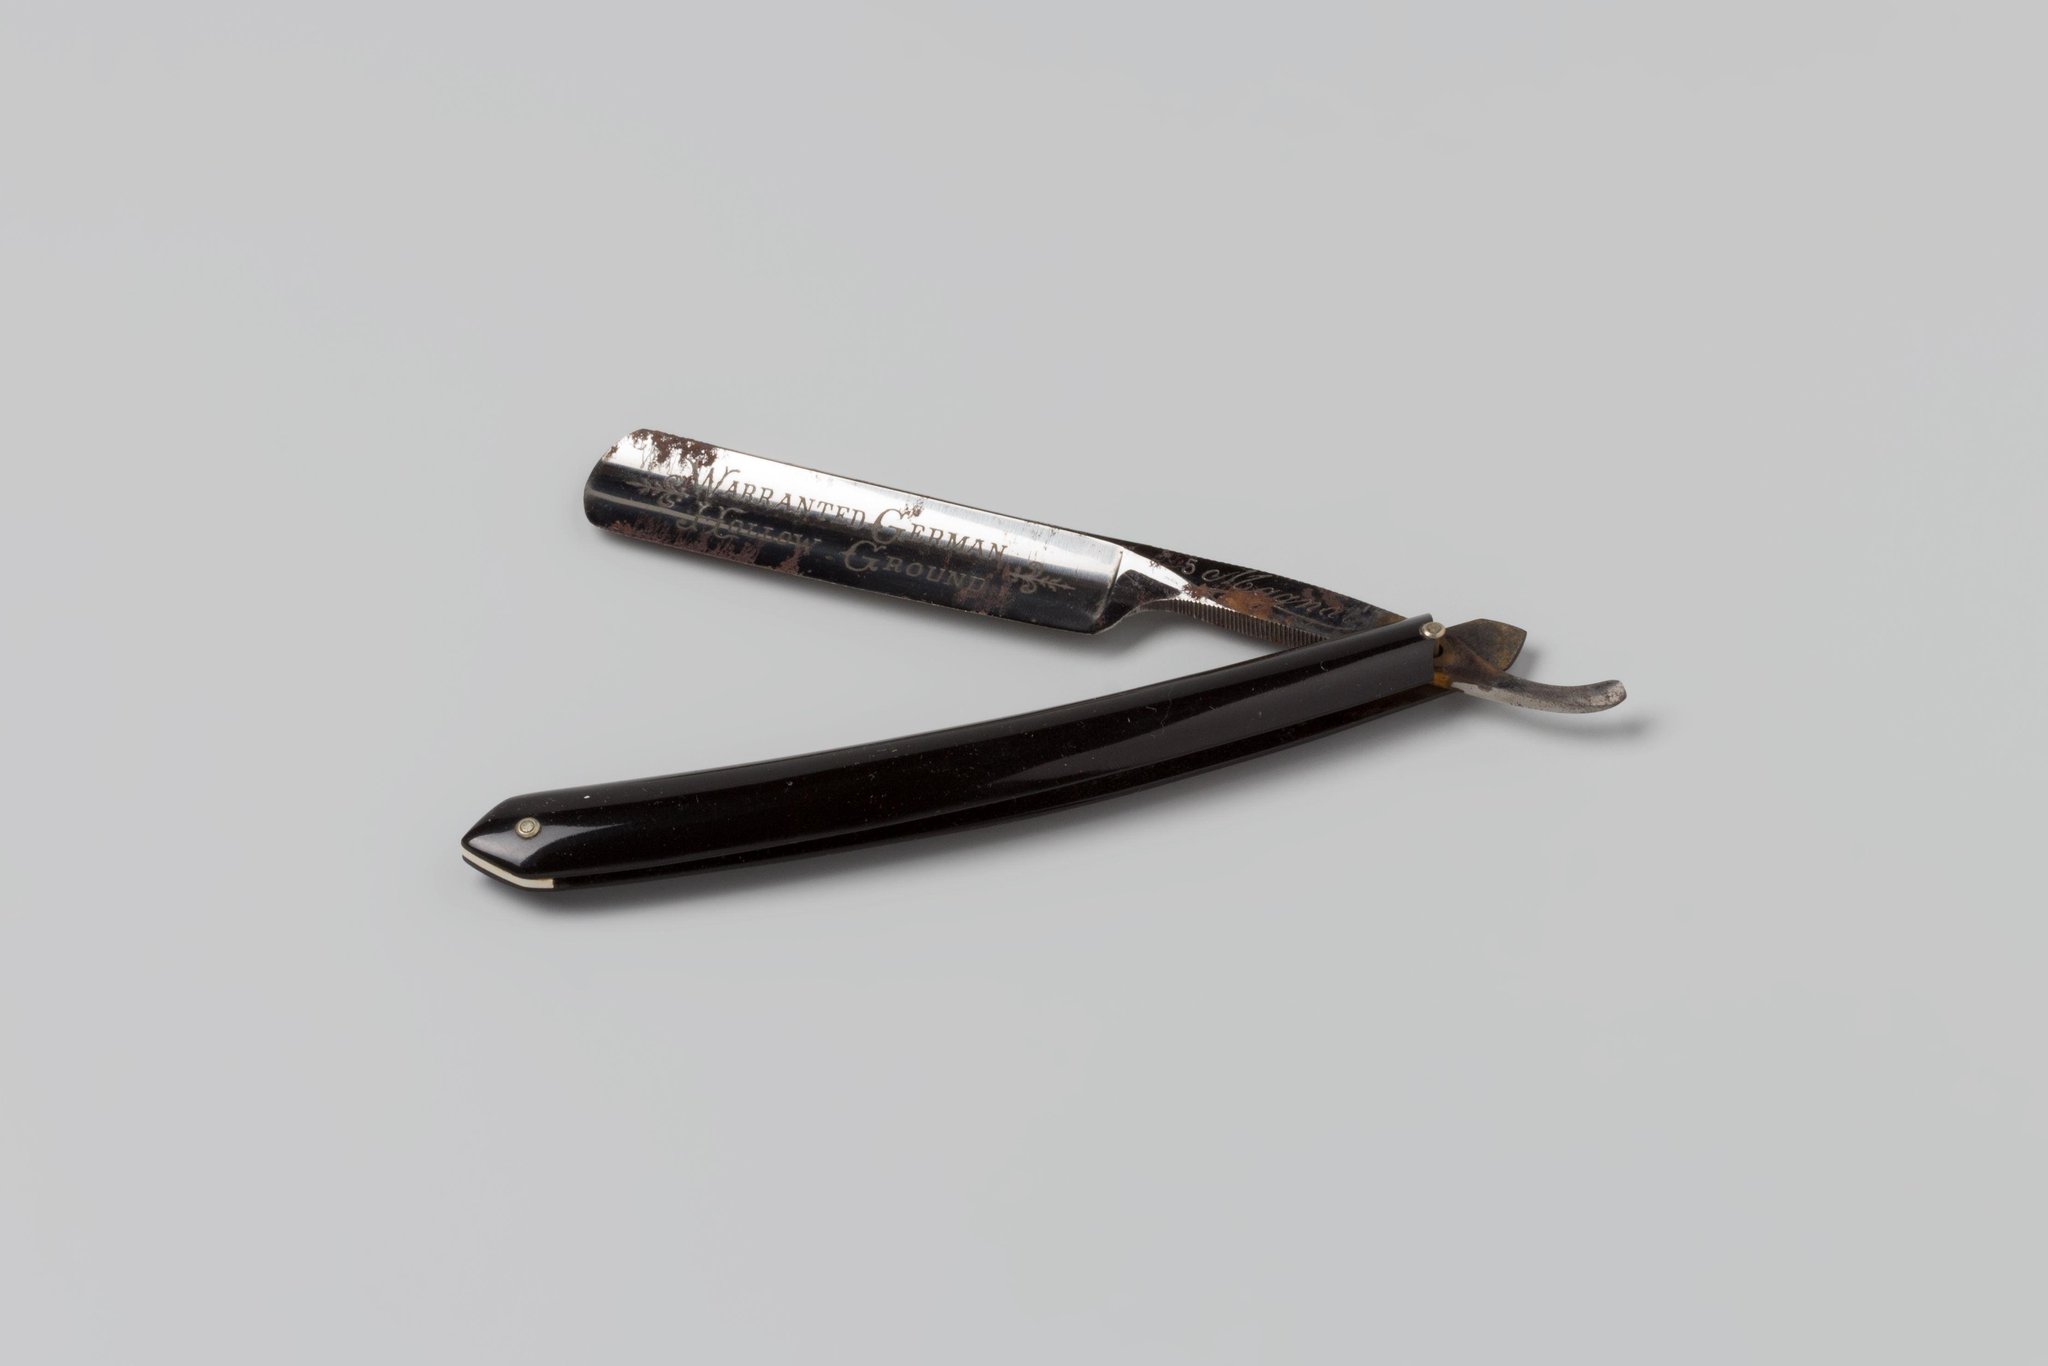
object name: scheermes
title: Scheermes van staal met het lemmet overlangs gebogen en een vatting van zwart bakeliet (?)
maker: Anonymous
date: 1925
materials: bakelite, steel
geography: sheffield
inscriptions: inscription: ‘'Warranted German/HOLLOW GROUD'’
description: Scheermes van staal. Model: knipmes, het lemmet overlangs gebogen. Vatting van zwart bakeliet (?) Op het mes: Warranted German/HOLLOW GROUD. In kartonnen foedraal met schuifdeksel, beplakt met zwart gegranuleerd papier.